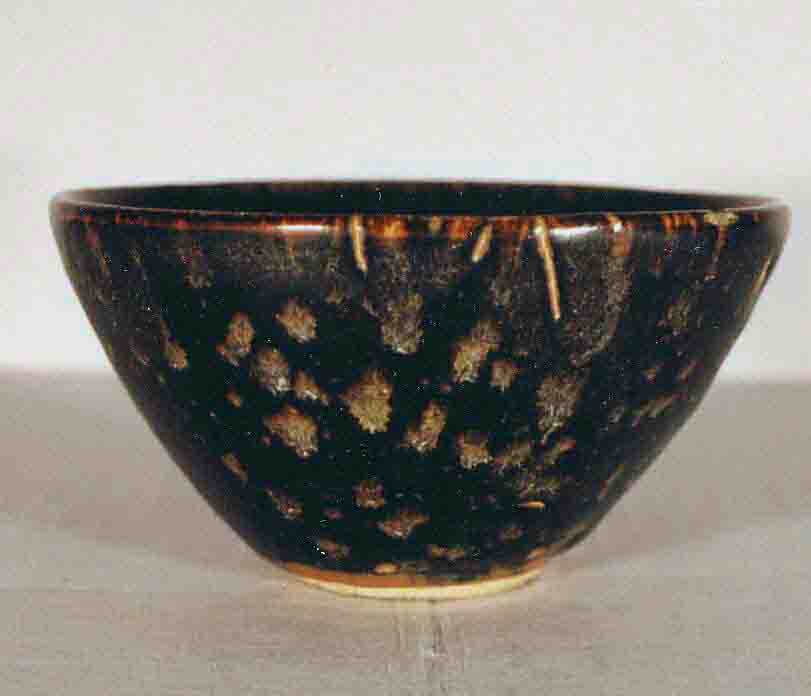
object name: cup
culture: chinese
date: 960-1279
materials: pottery